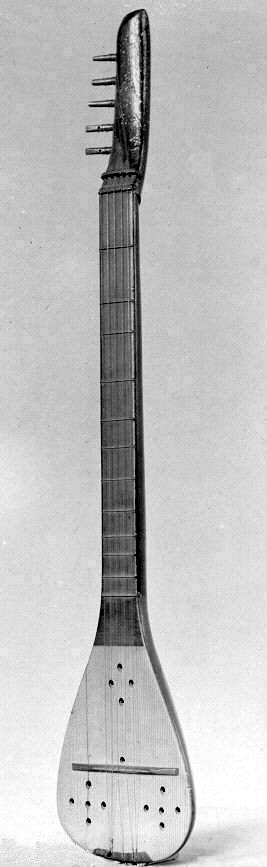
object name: stringed instrument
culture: arabian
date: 1867-1900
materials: wood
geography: arabia